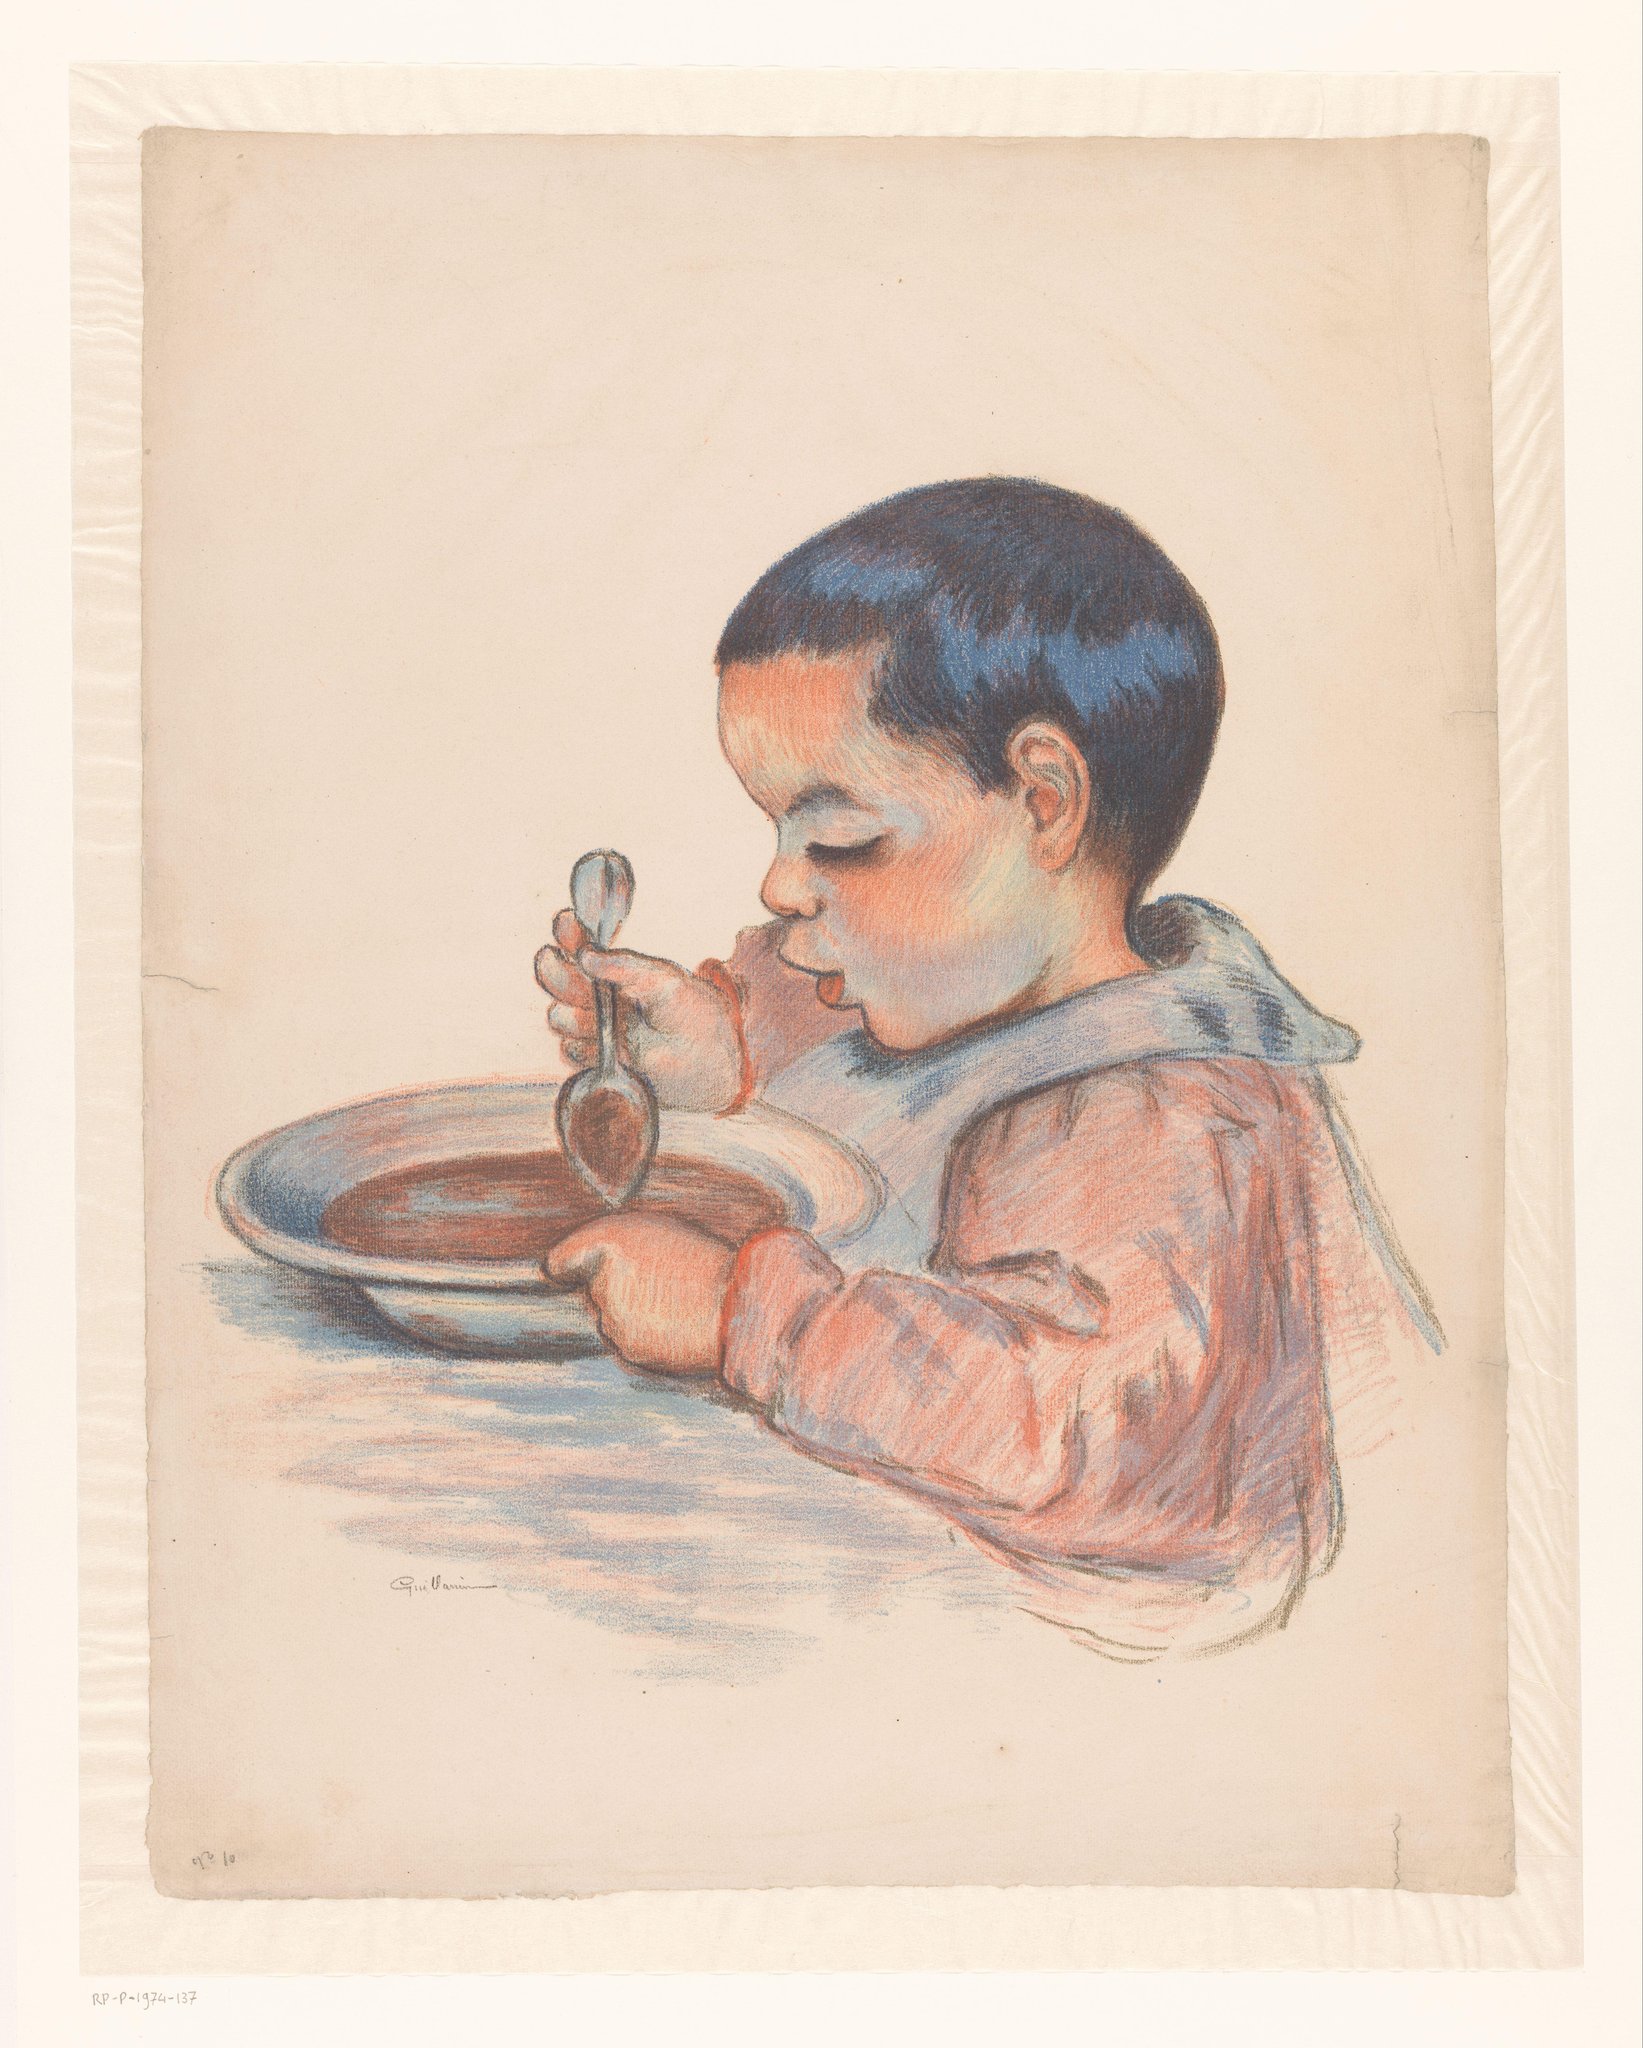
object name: print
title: Kind dat soep eet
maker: armand guillaumin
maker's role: print maker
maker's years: 1841-1927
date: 1900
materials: paper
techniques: lithograph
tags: toddler, spoon, eating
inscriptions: collector's mark: Lugt 2760, collector's mark: Lugt 2228, inscription: ‘[...] 10’, watermark